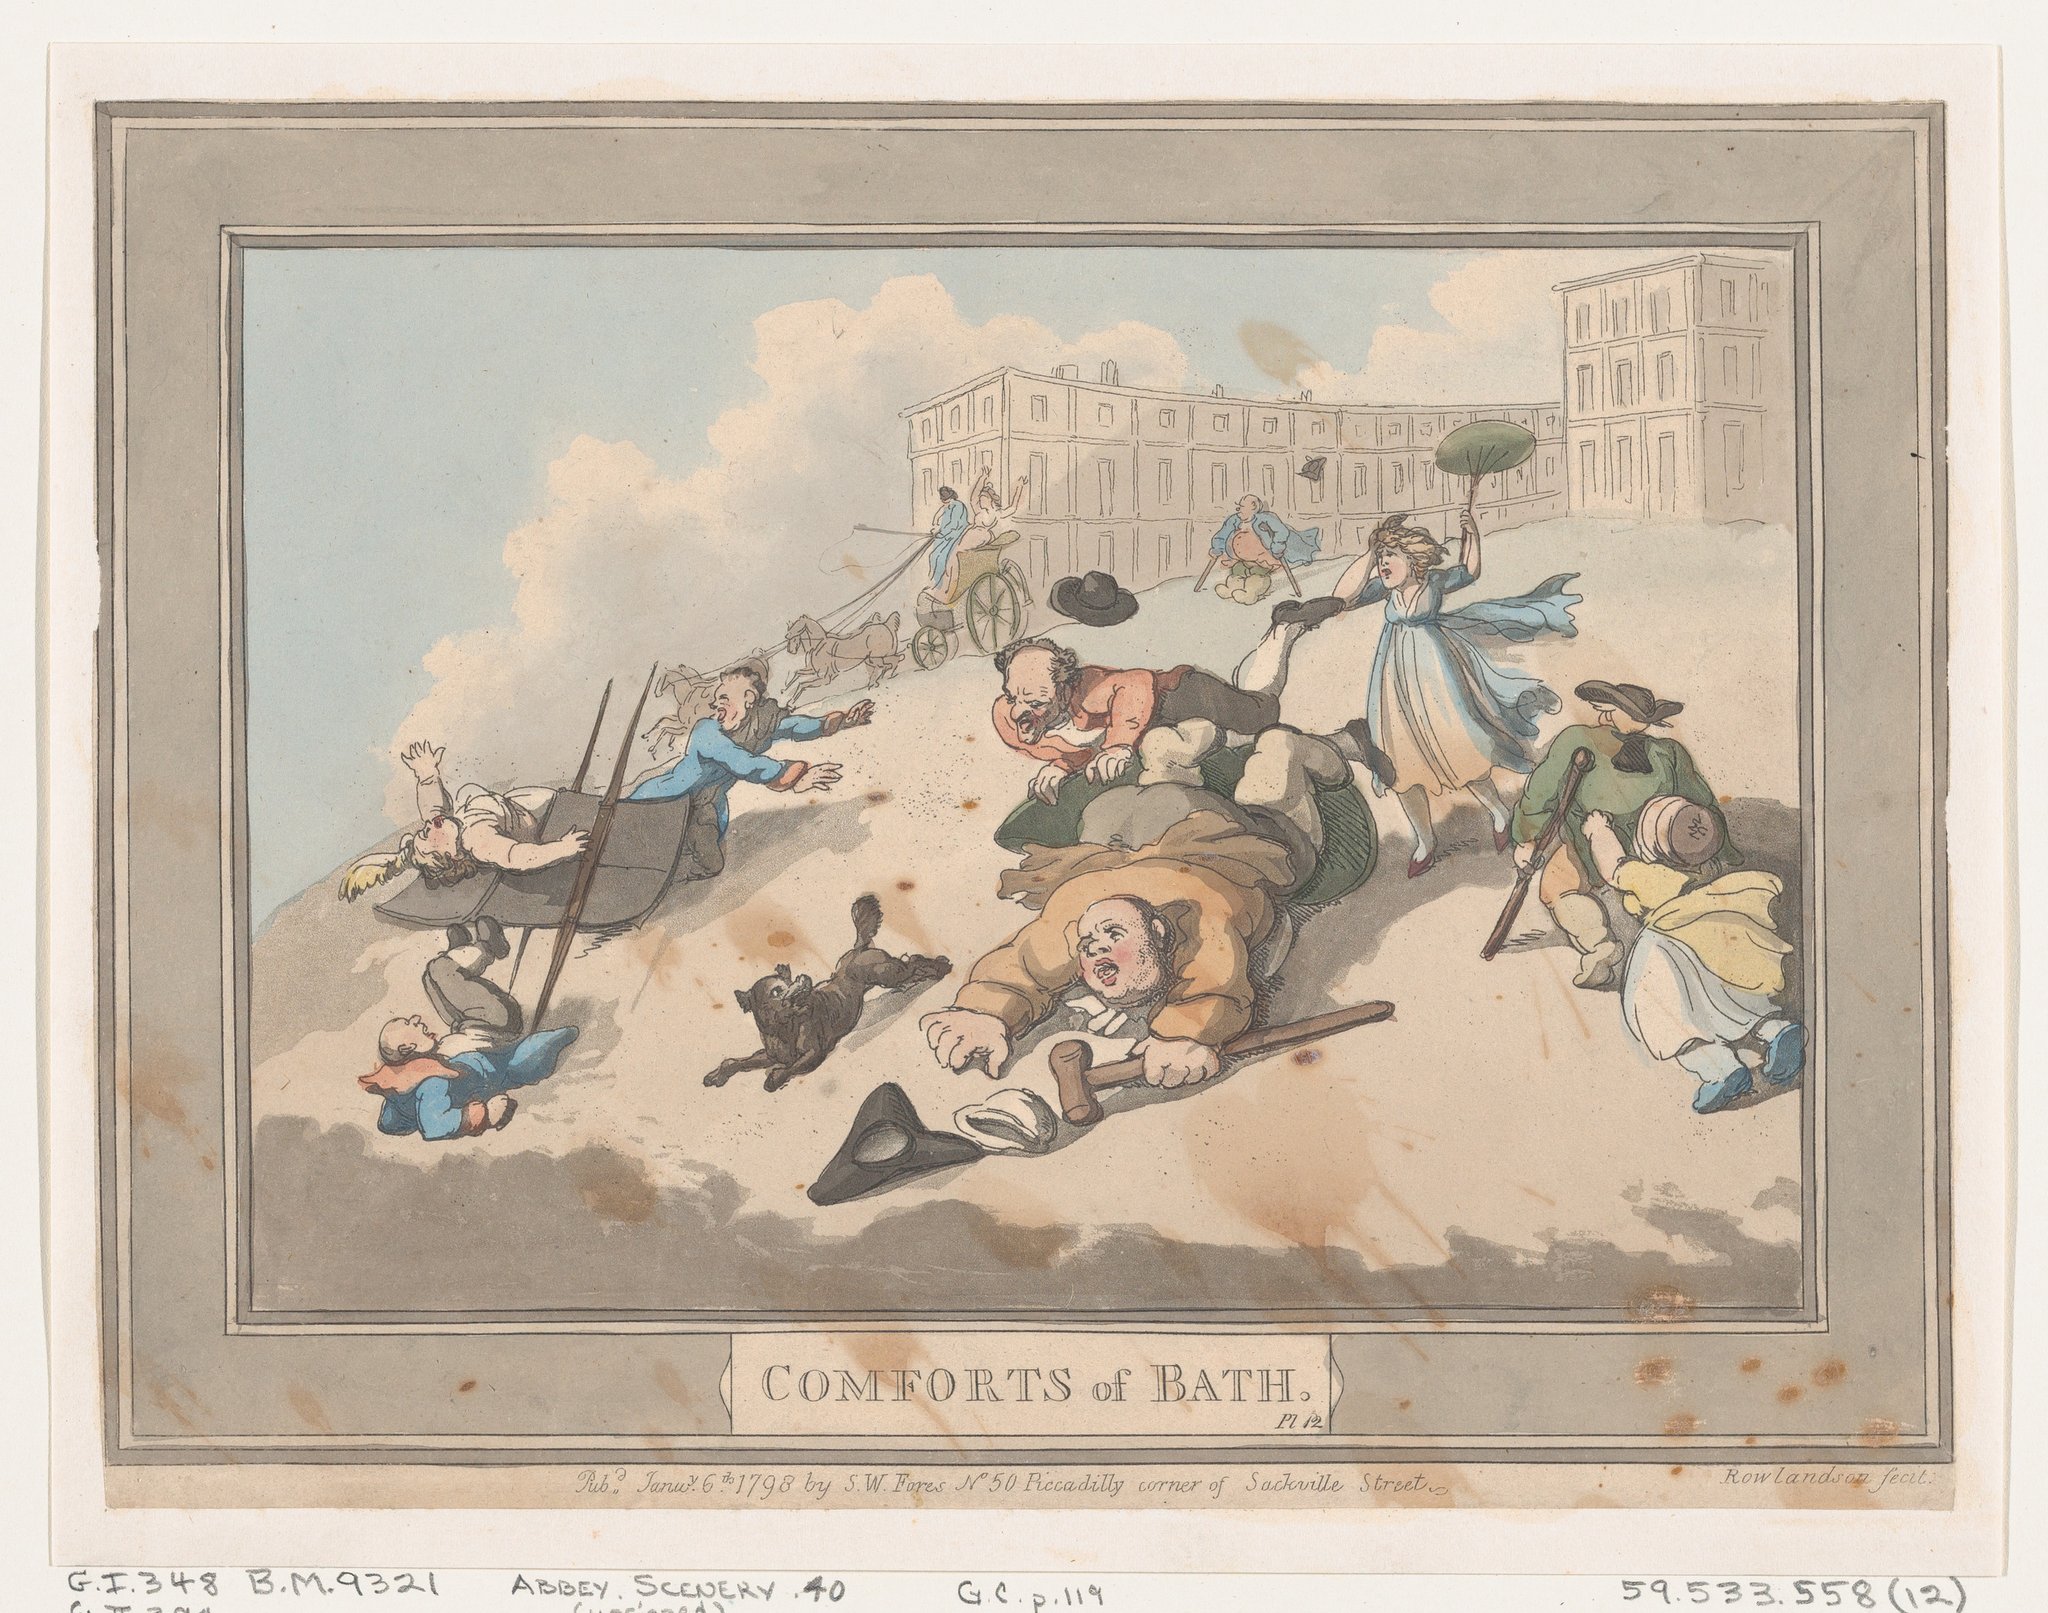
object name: print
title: Comforts of Bath, Plate 12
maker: thomas rowlandson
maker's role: artist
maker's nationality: british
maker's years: 1757-1827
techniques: aquatint, etching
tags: men,women,storms